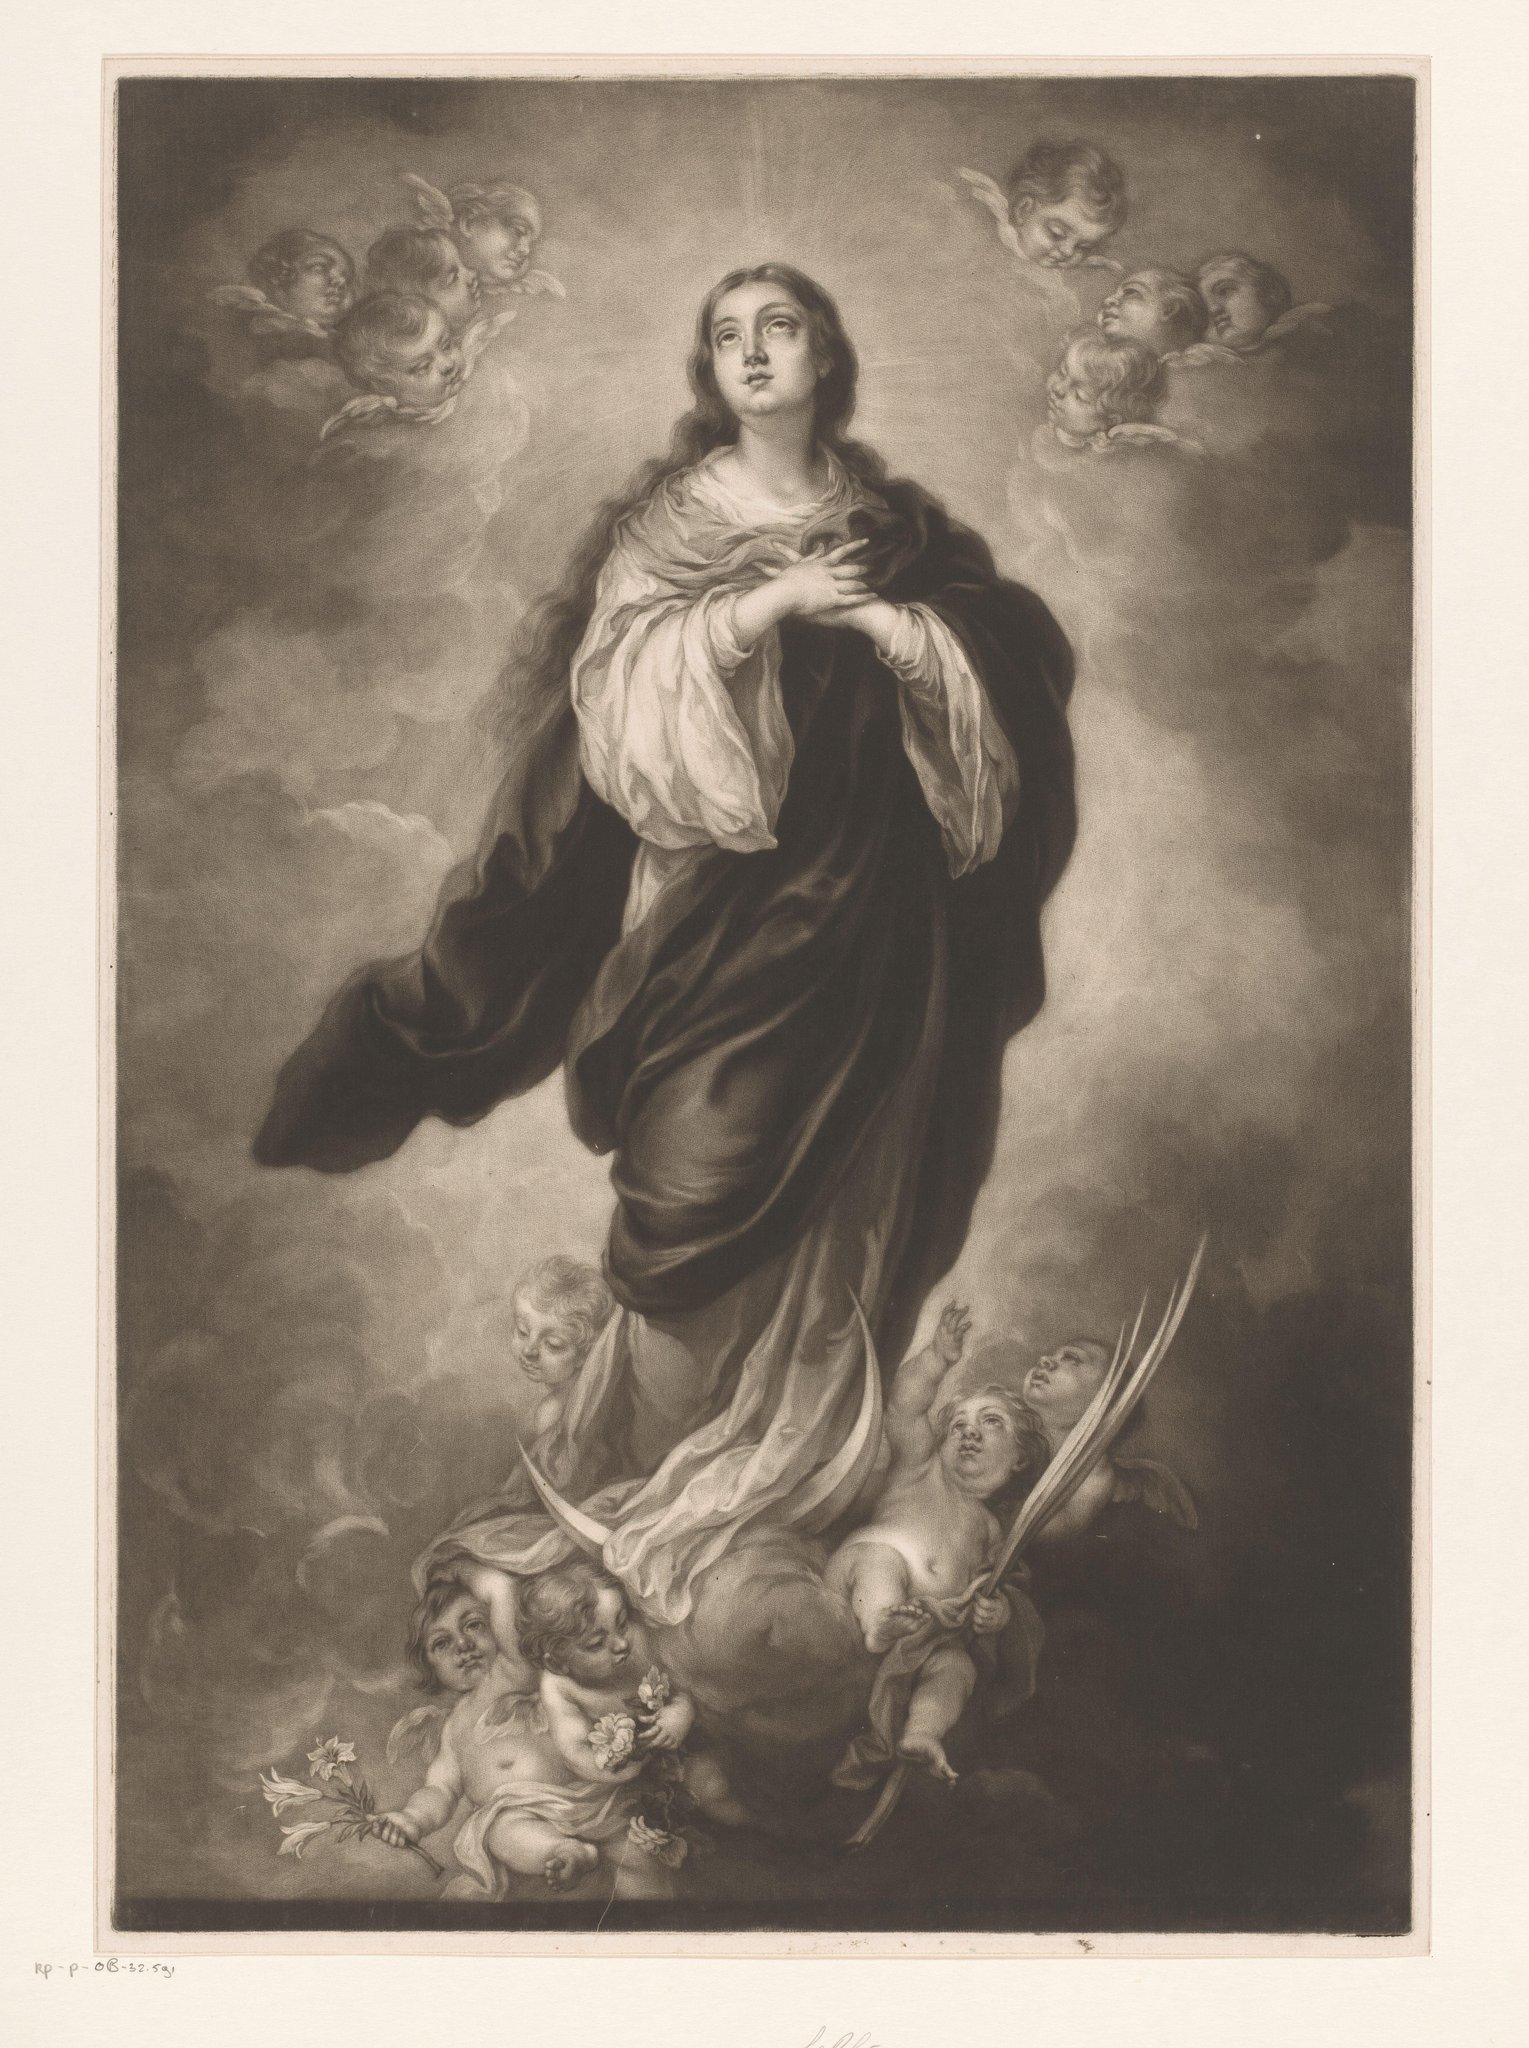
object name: print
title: Maria van de Onbevlekte Ontvangenis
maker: james mcardell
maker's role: print maker, publisher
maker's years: 1728-1765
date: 1745-1765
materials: paper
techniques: mezzotint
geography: london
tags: (immaculate) conception of mary represented symbolically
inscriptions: collector's mark: Lugt 240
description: Maria staand op een wolk met een halve maan, gedragen door putti. Zij houden een palmtak, rozen en lelies vast.